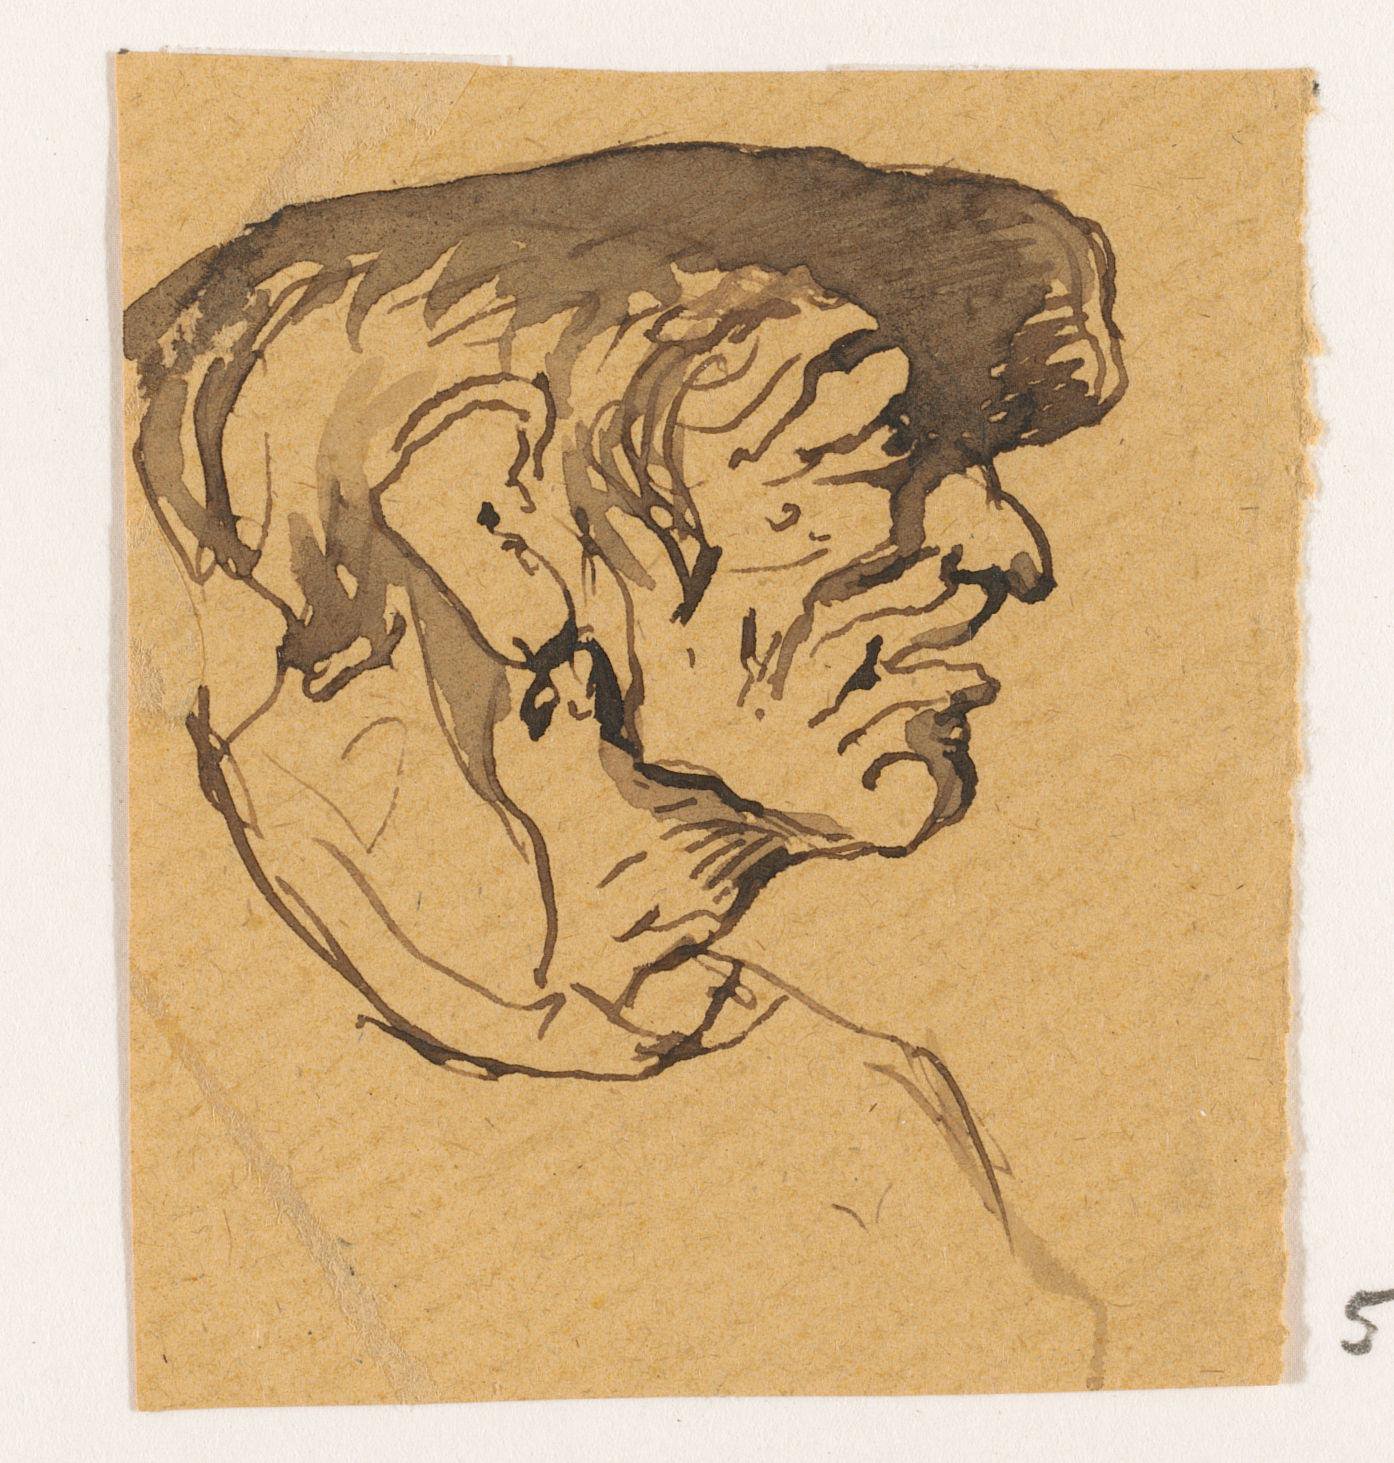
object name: drawing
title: Kop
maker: johannes tavenraat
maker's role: draughtsman, painter, print maker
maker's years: 1809-1881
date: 1840-1880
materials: ink, paper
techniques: pen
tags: caricatures (human types)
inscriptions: collector's mark: Lugt 2228